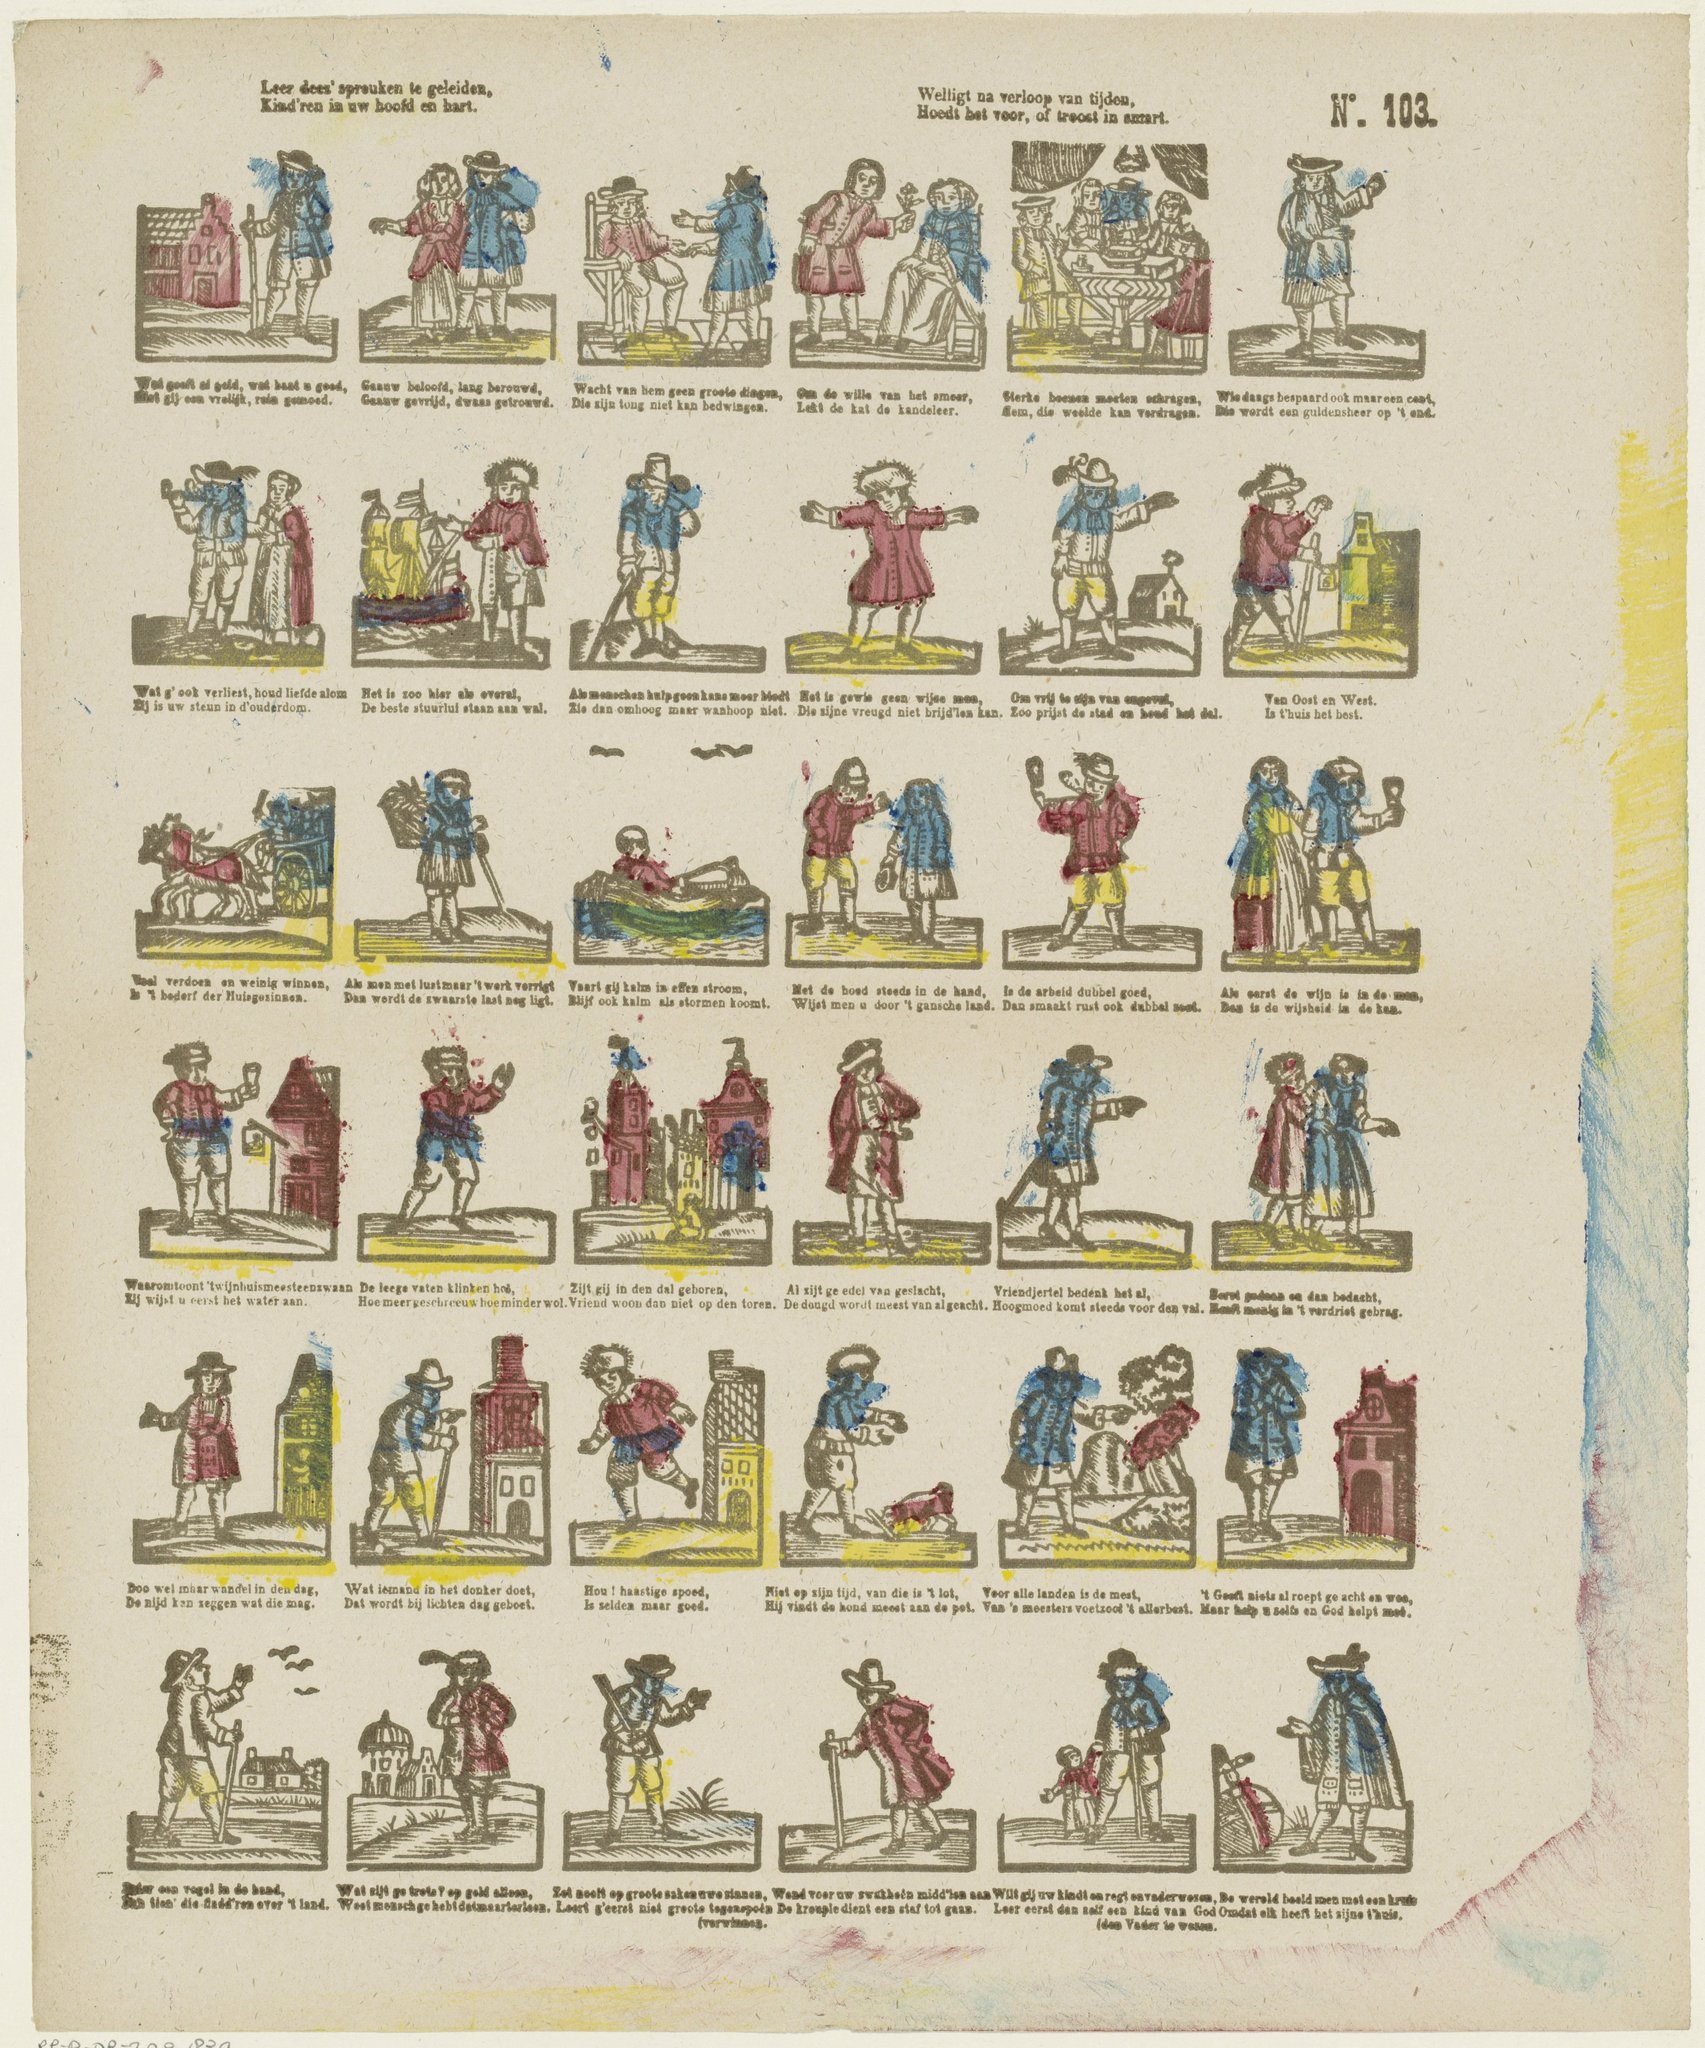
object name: popular print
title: Leer deez' spreuken te geleiden, / Kind'ren in uw hoofd en hart / Welligt na verloop van tijden, / Hoedt het voor, of troost in smart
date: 1827-1894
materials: paper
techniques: printing, colour, letterpress printing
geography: schaarbeek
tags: proverbs, sayings, etc.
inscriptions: collector's mark: Lugt 2760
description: Blad met 36 verbeeldingen van spreekwoorden en gezegden. Onder elke afbeelding een tweeregelig vers. Genummerd rechtsboven: No. 103.